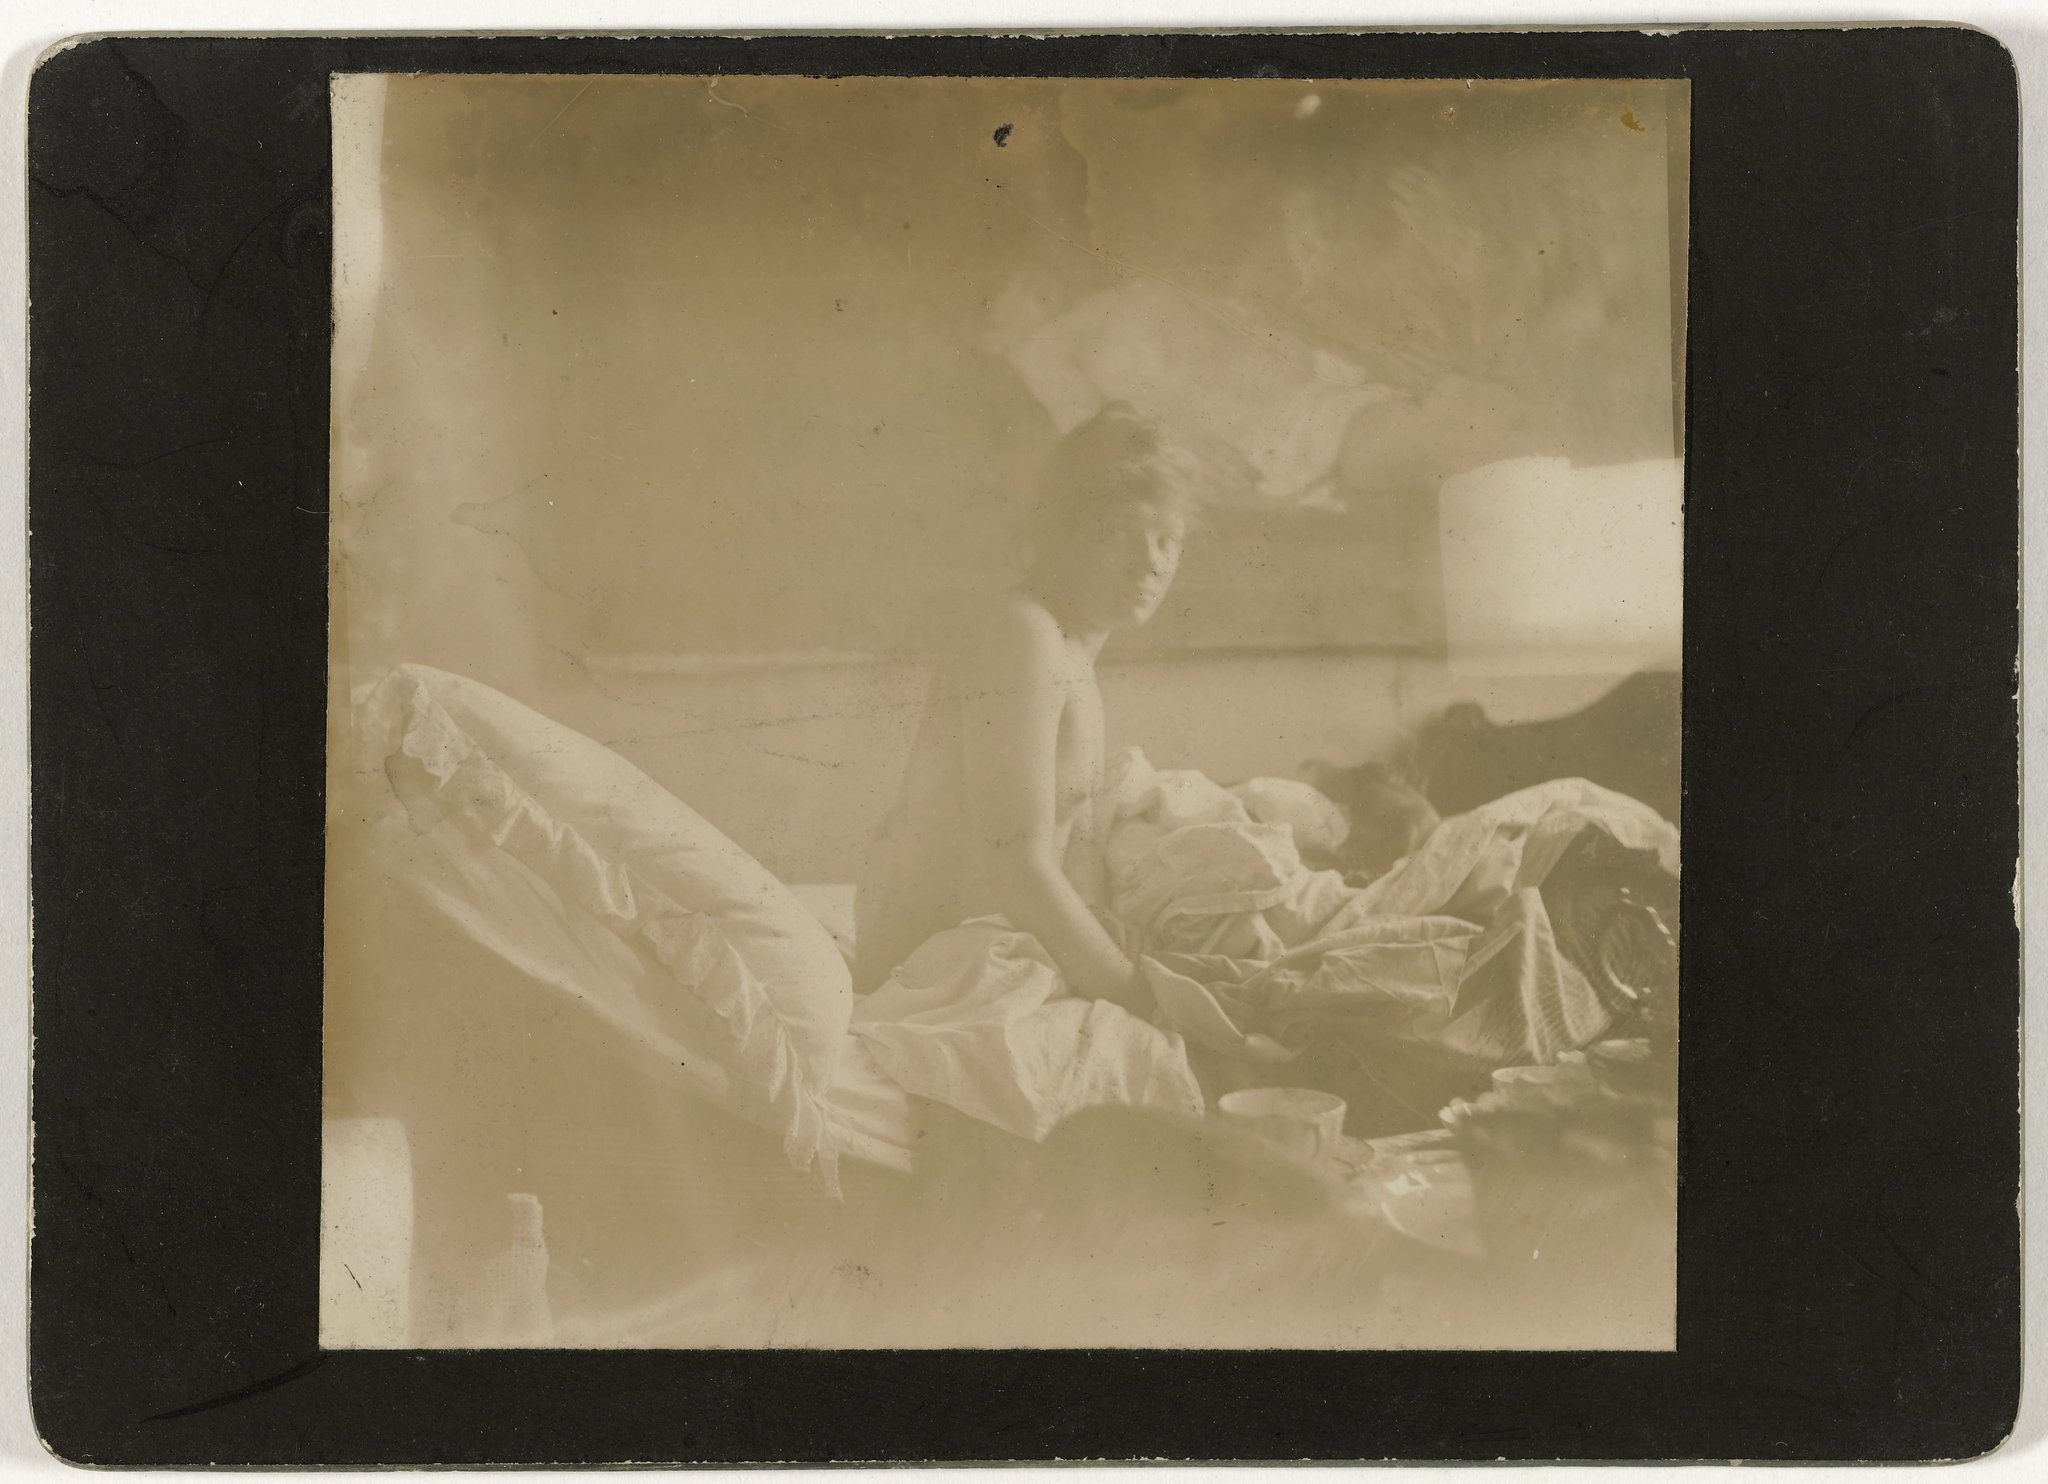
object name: photograph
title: Portret van Marie Jordan zittend naakt op bed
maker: george hendrik breitner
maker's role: draughtsman, painter, print maker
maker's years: 1857-1923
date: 1890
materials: cardboard, photographic support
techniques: gelatin silver print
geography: amsterdam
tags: amsterdam, marie jordan, historical persons - bb - woman, the (nude) human figure; 'corpo humano' (ripa) - aa - female human figure (+ sideview, profile)